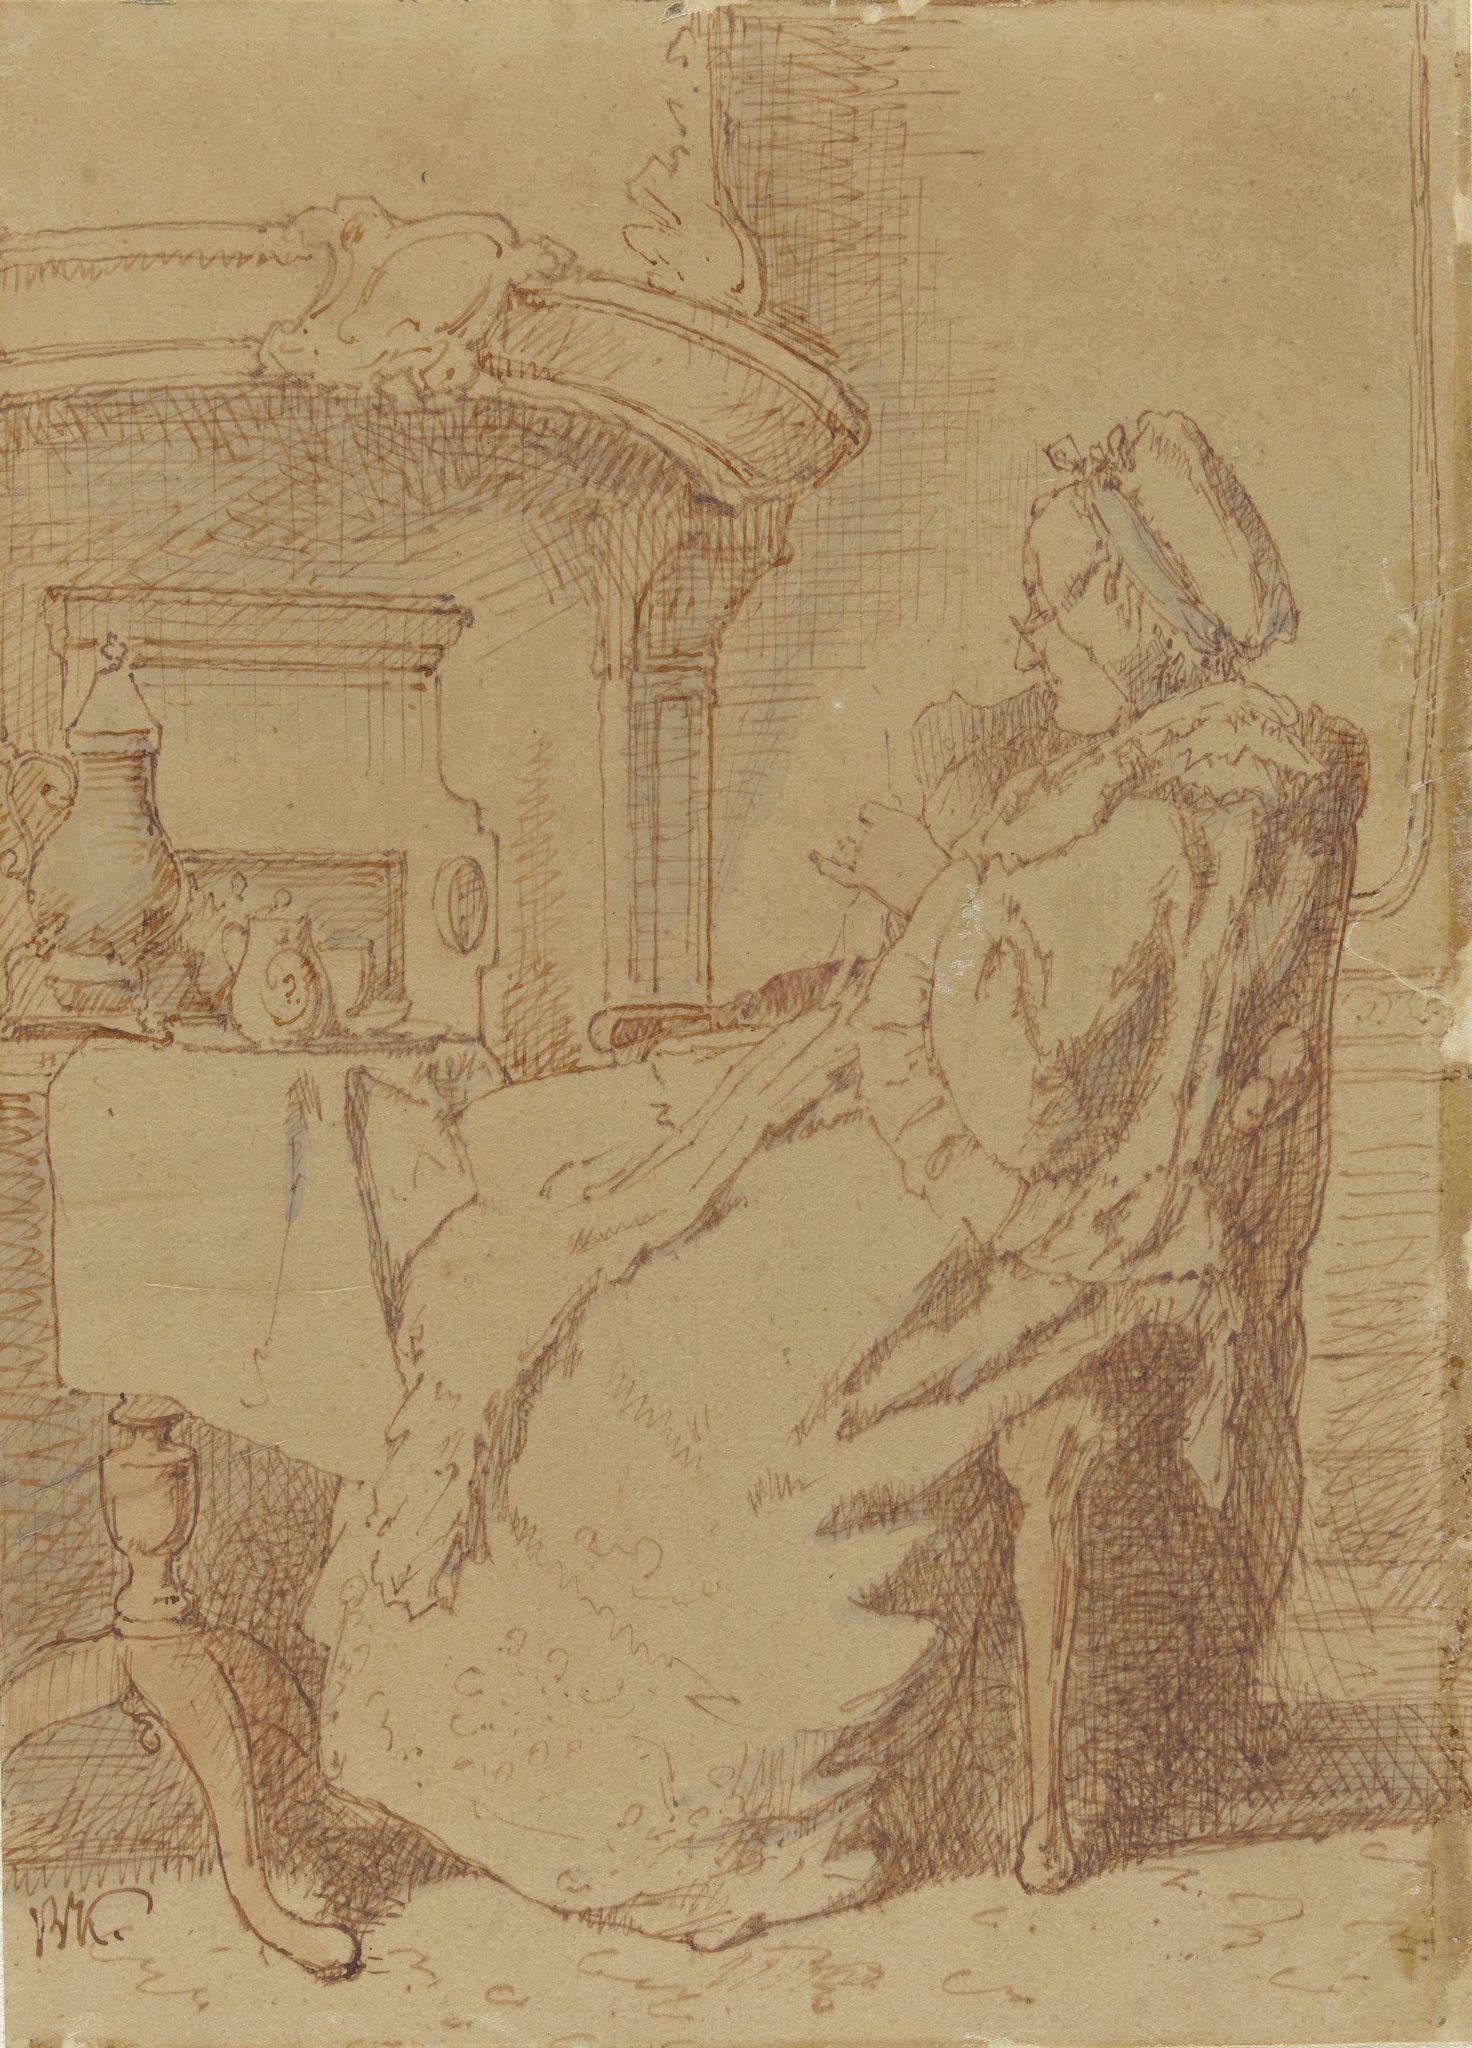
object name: drawing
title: Zittende, breiende oude vrouw aan een tafel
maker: alexander hugo bakker korff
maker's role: draughtsman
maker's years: 1824-1882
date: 1834-1882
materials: ink, paper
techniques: brush, pen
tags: knitting